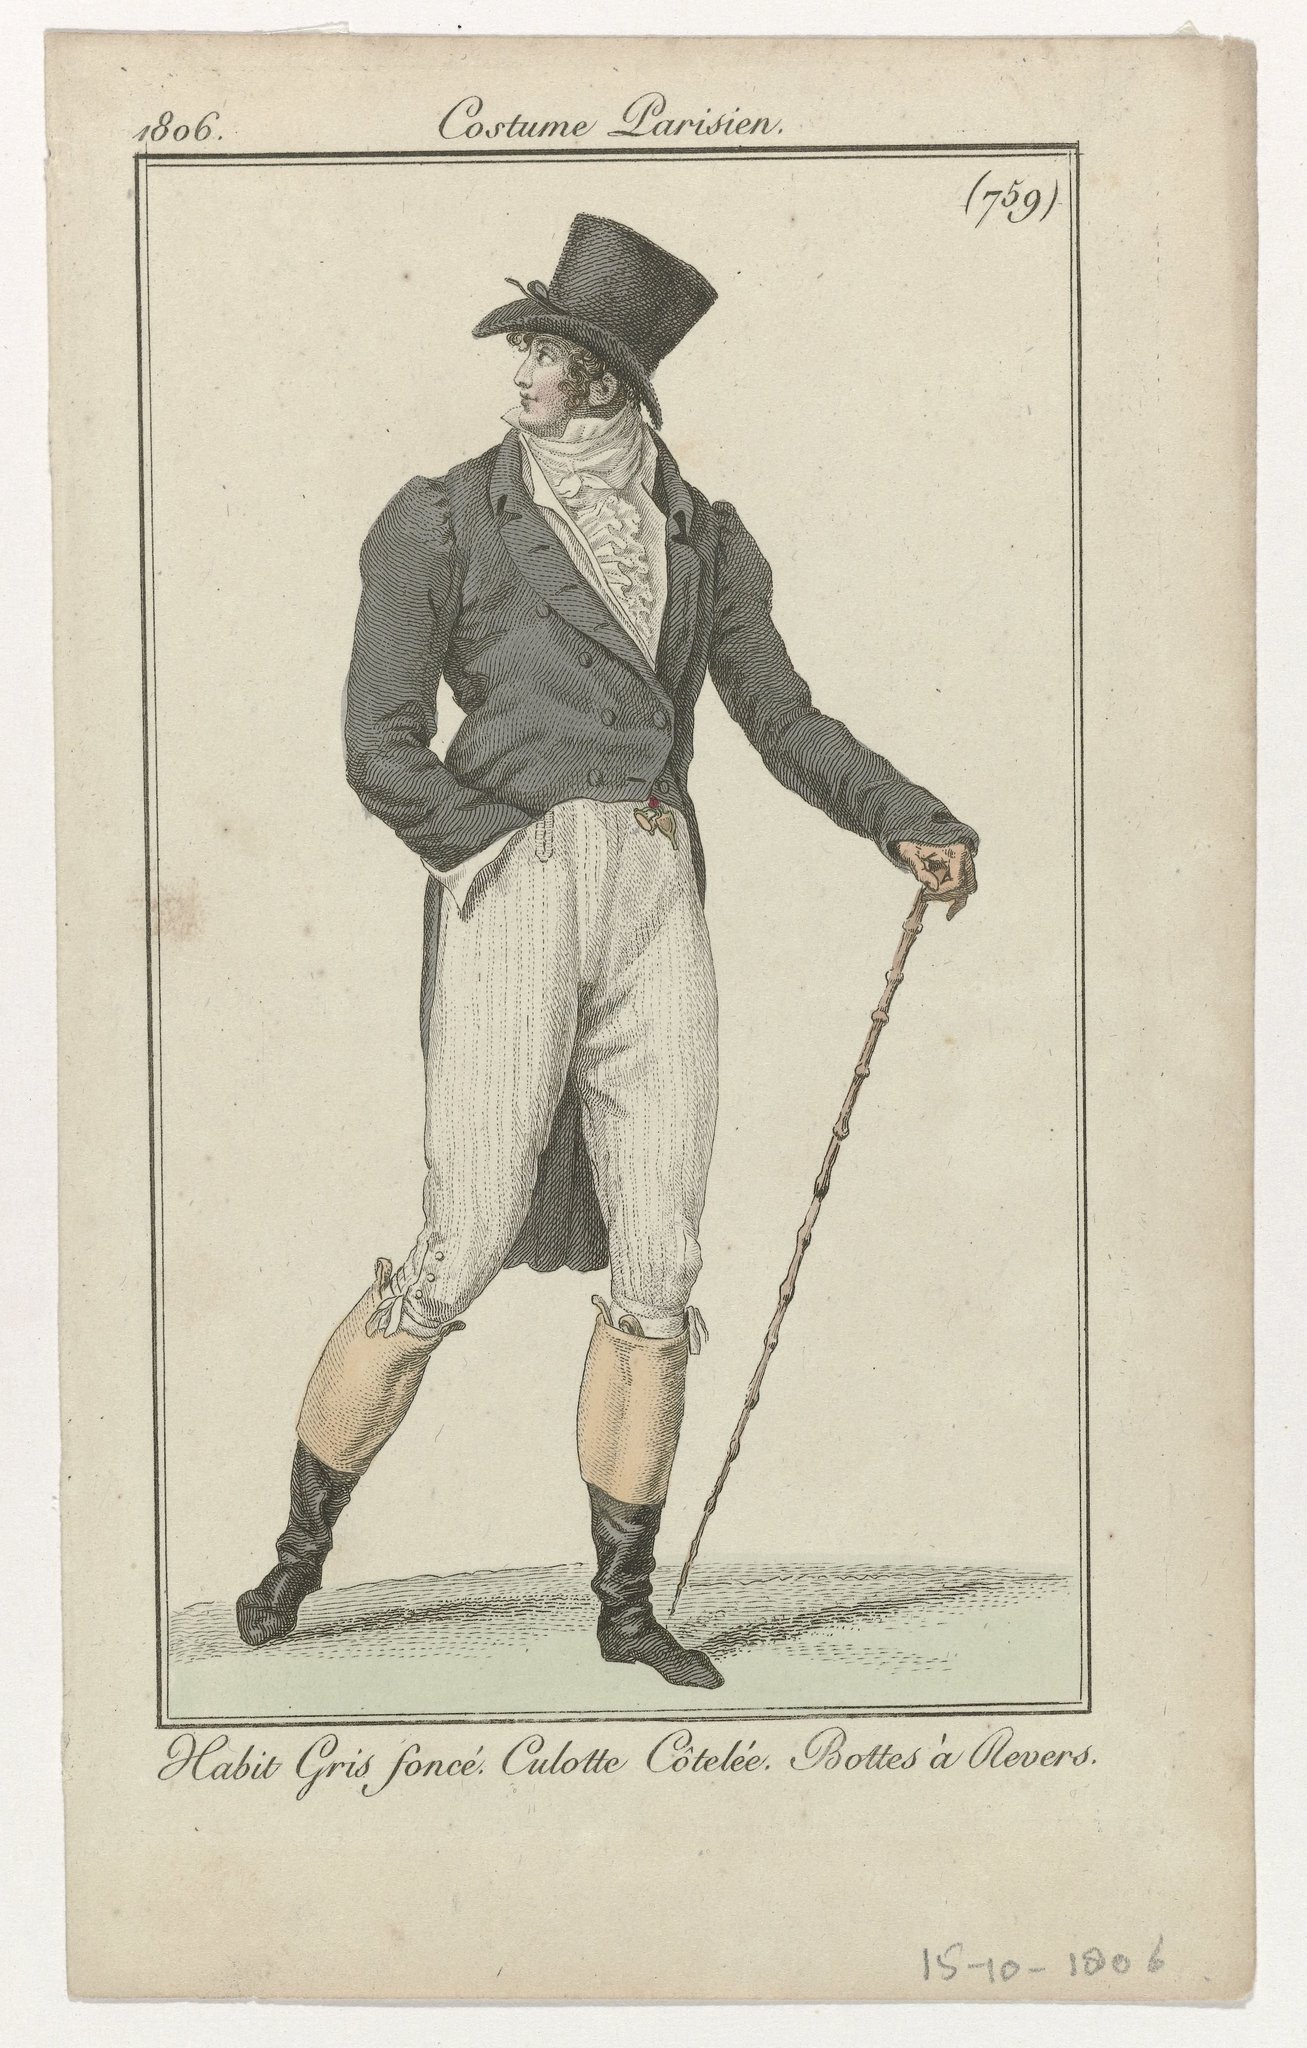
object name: fashion print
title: Journal des Dames et des Modes: Men’s Fashion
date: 1806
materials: paper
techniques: engraving, hand coloring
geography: paris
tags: clothing for the upper part of the body (vest) (+ men's clothes), coat (+ men's clothes), fashion plates, gloves, mittens, etc. (+ women's clothes), trousers, breeches, etc. (breeches) (+ men's clothes), boots (+ men's clothes), walking-stick, staff, cane (+ men's clothes)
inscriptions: title: ‘Costume Parisien.’, caption: ‘Habit Gris foncé. Culotte Côtelée. Bottes à Revers.’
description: The Journal des Dames et des Modes occasionally provided coverage of men’s styles. These illustrations give a good picture of trends in mens’ clothing from 1797 to 1825. During the 18th century, gentlemen wore culotte (knee-breeches) 1. These fell out of fashion with the elimination of strict class distinctions during the French Revolution, to be replaced by a type of long trouser(s) known as pantalon à la Hussarde 2. These were worn with hussar boots. ‘Pantaloons’ 3 were trousers pulled tight with an elastic strap under the instep. Carrick 4 coats with a double collar were popular, and in the evenings men wore a special dress cloak 5.